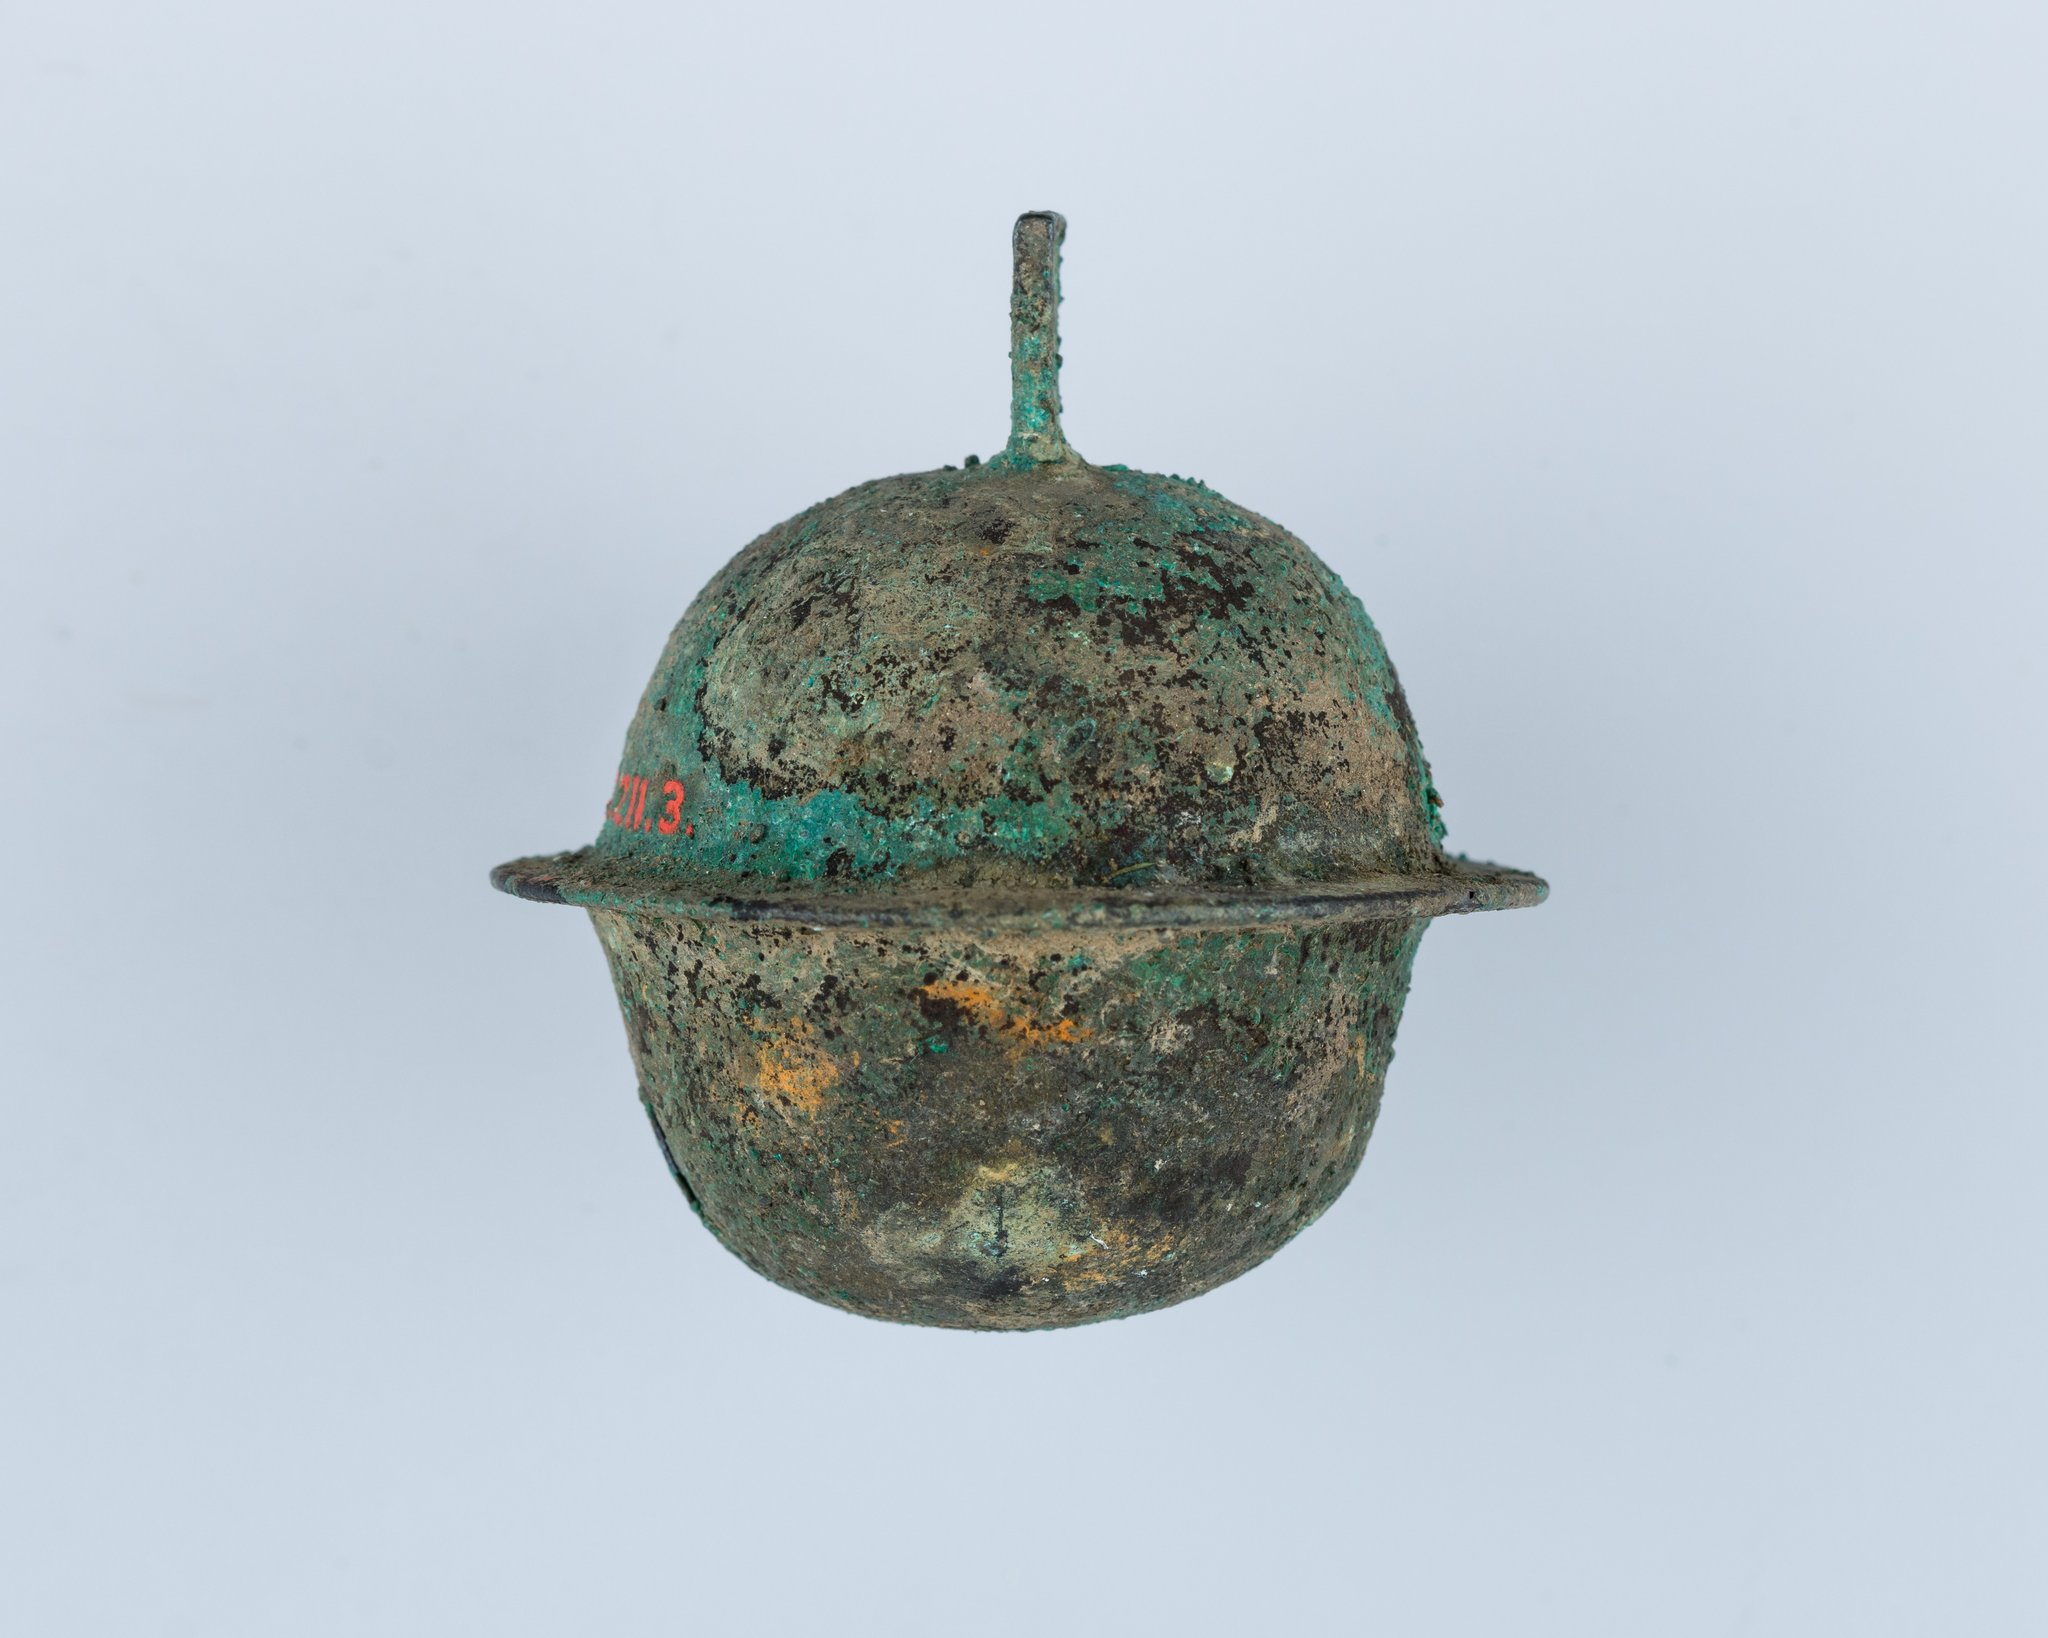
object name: bell, for a horse harness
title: Bells, Probably for a Horse Harness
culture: japanese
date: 201-300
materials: bronze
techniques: gilding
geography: japan